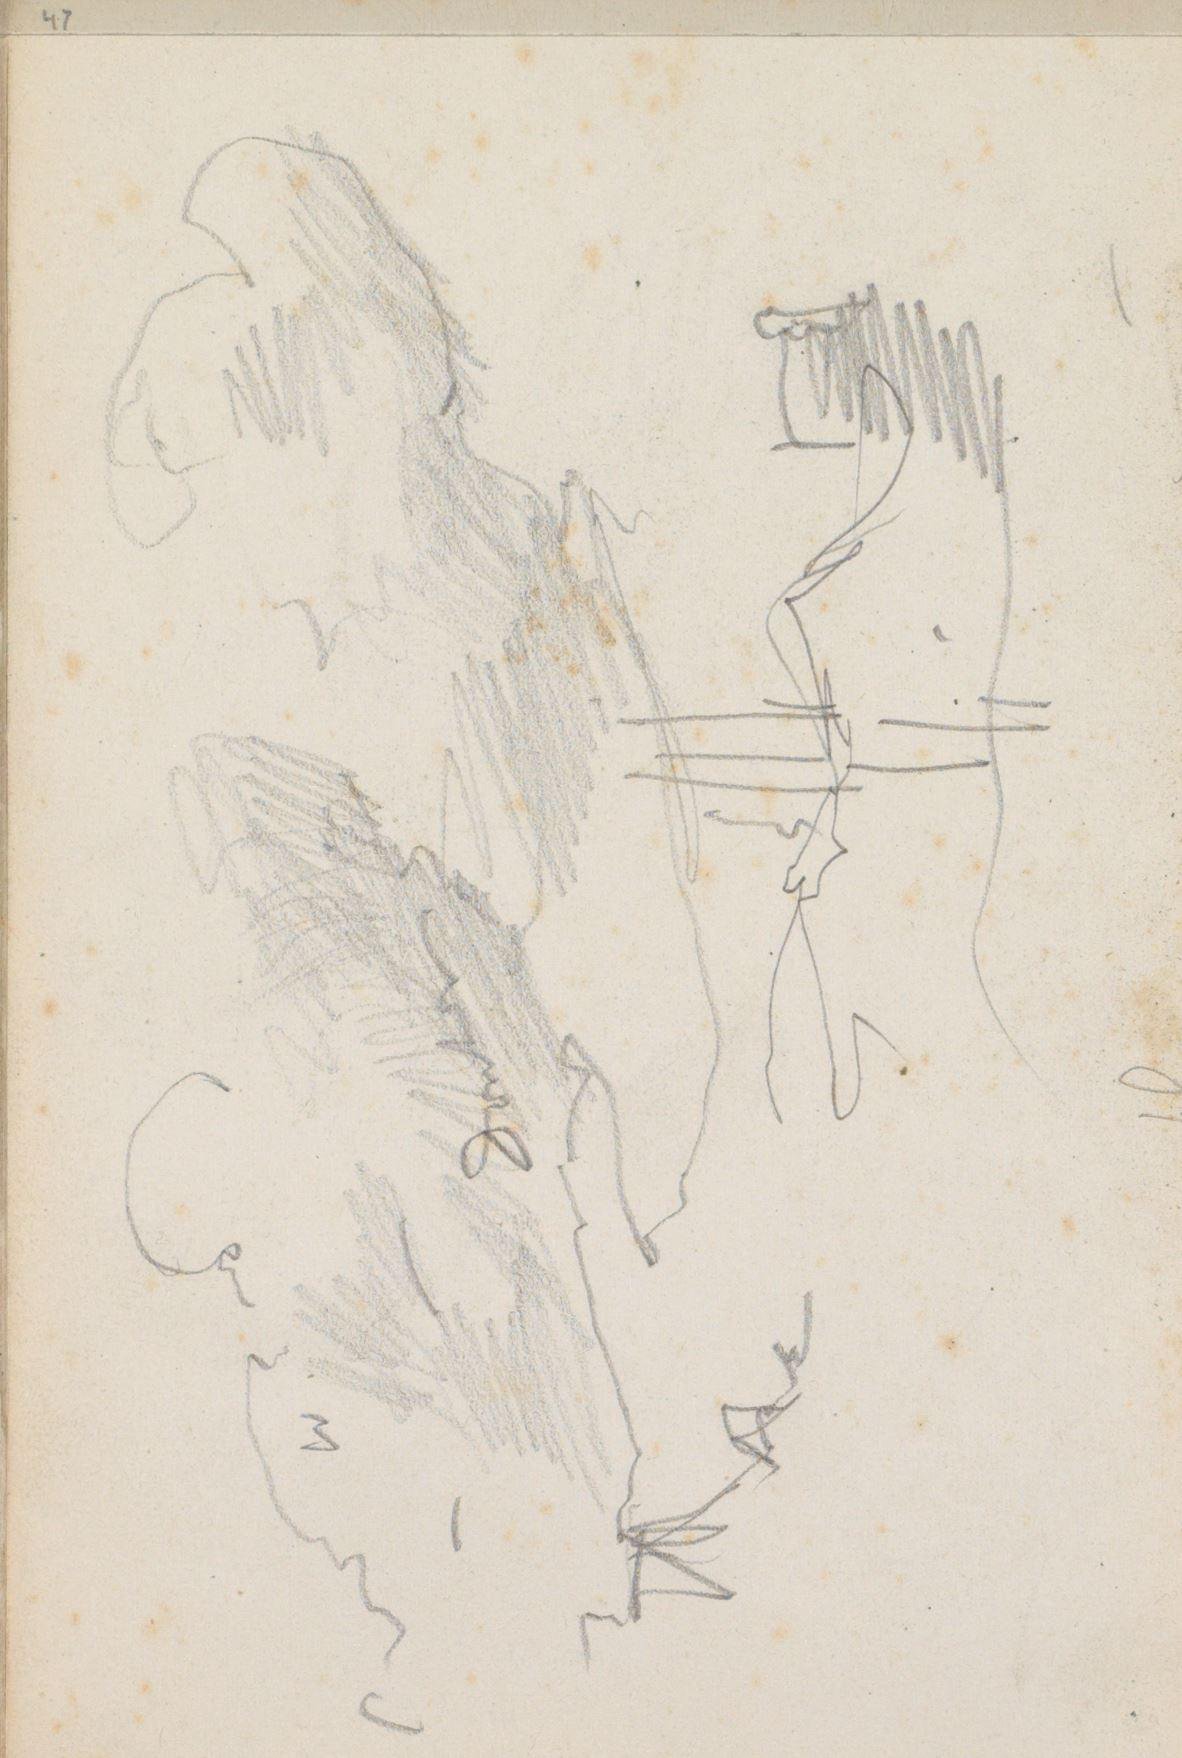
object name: sketchbook leaf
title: Landschap met wolkenlucht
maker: george hendrik breitner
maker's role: draughtsman, painter, print maker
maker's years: 1857-1923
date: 1880-1882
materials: paper, pencil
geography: south holland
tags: landscapes, clouds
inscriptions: kleurnotitie, handgeschreven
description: Pagina 47 uit een schetsboek met 72 bladen.